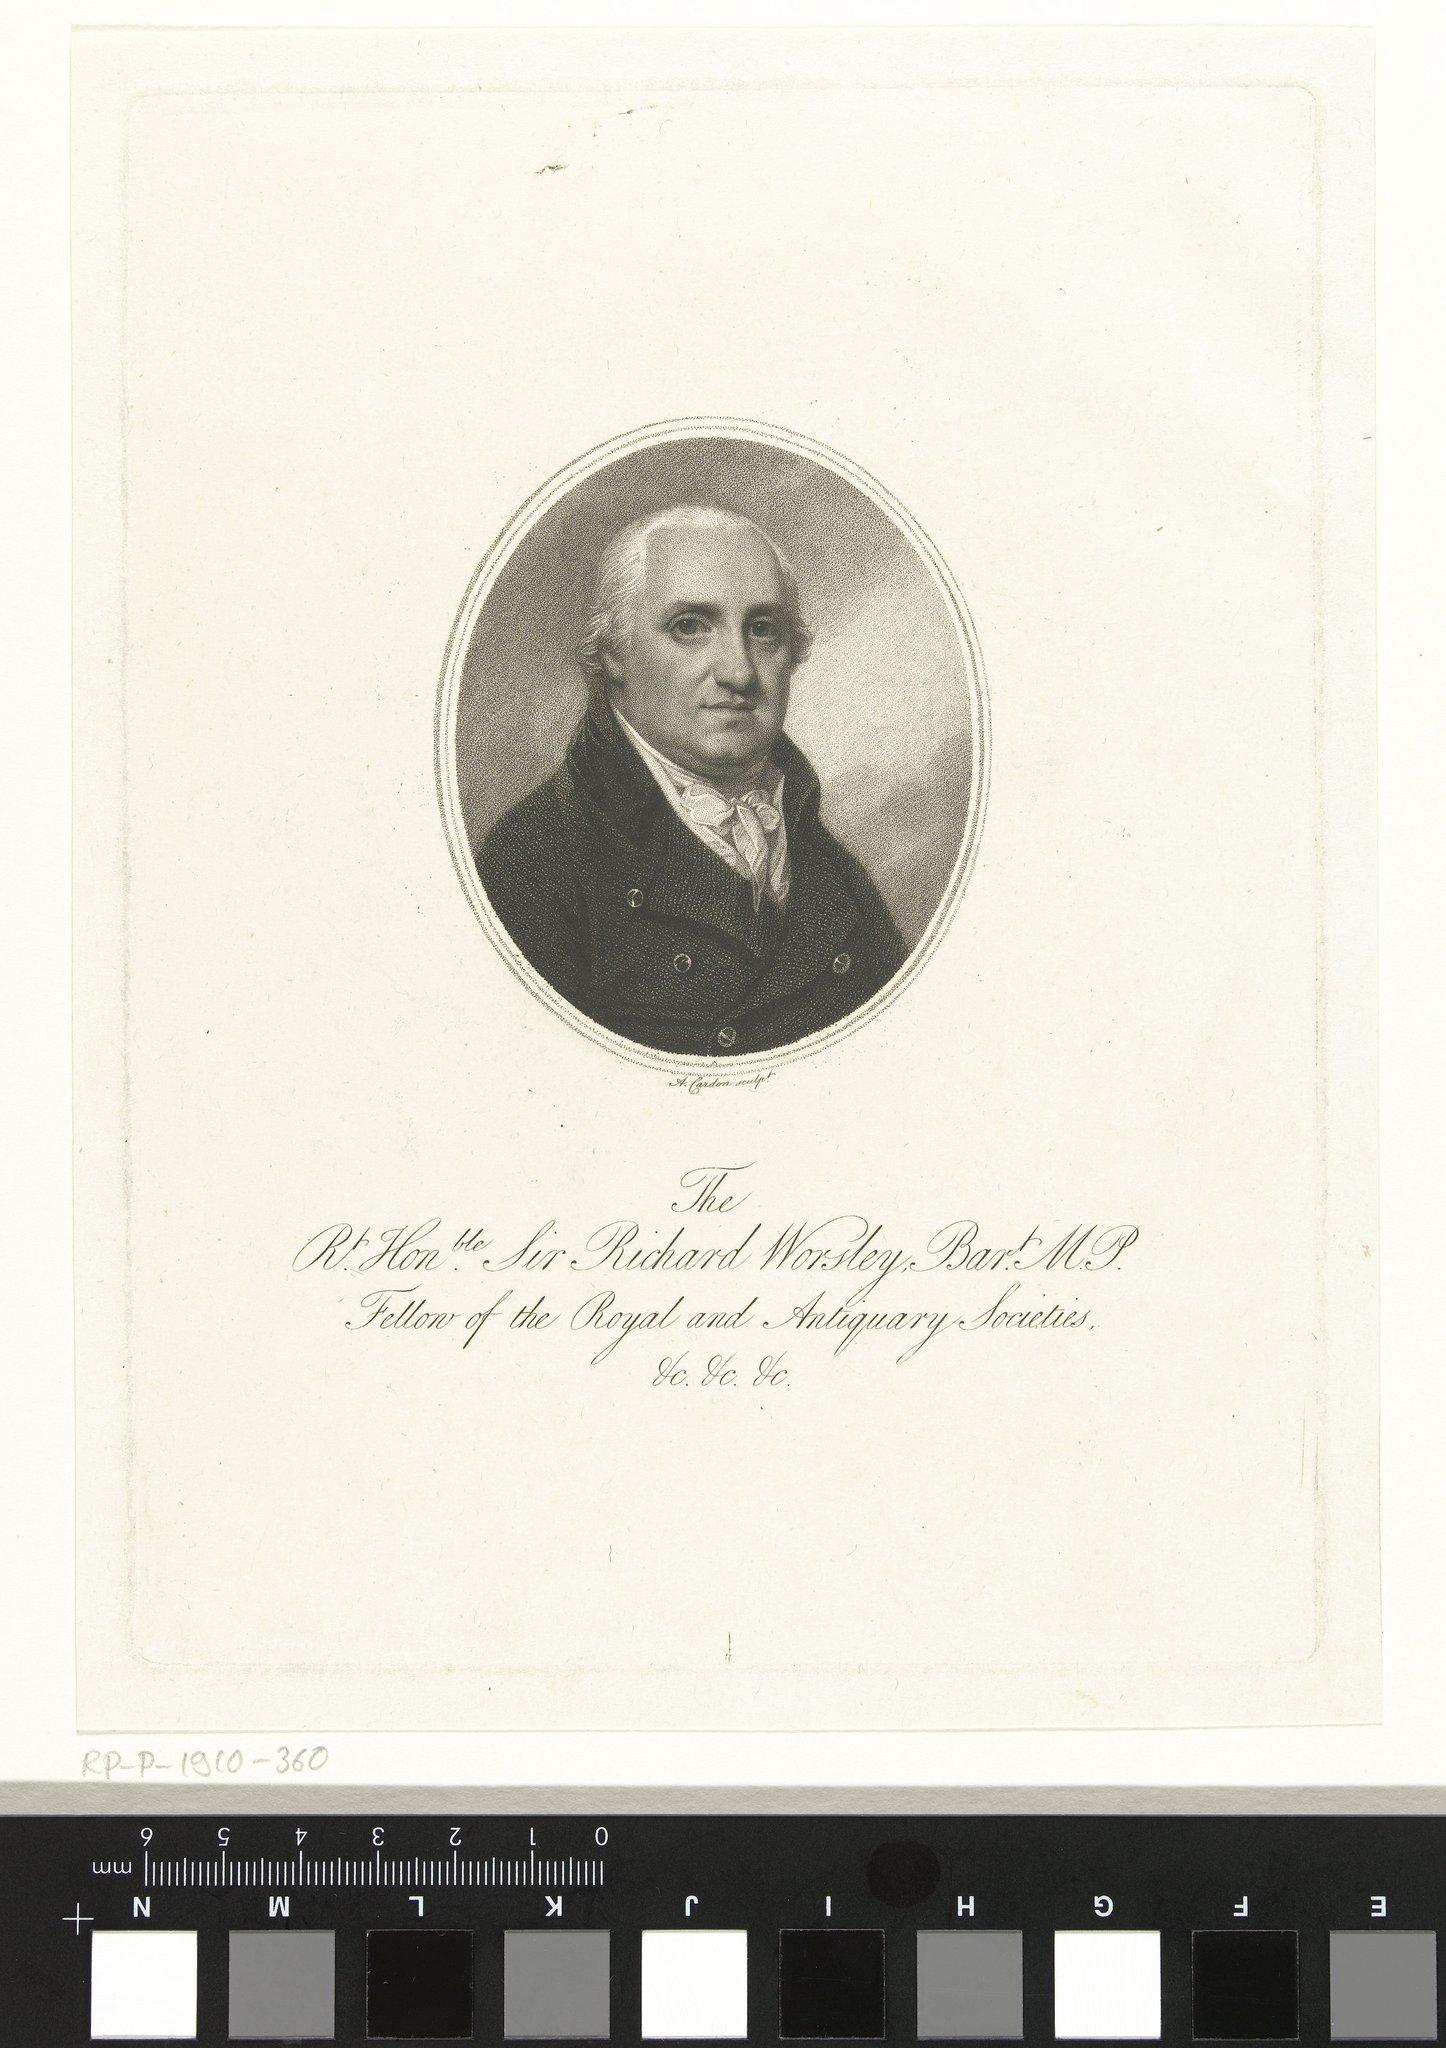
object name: print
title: Portret van Sir Richard Worsley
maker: antoine alexandre joseph cardon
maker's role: print maker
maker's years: 1739-1822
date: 1792-1813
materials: paper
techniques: etching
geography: london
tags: politician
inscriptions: collector's mark: Lugt 2228